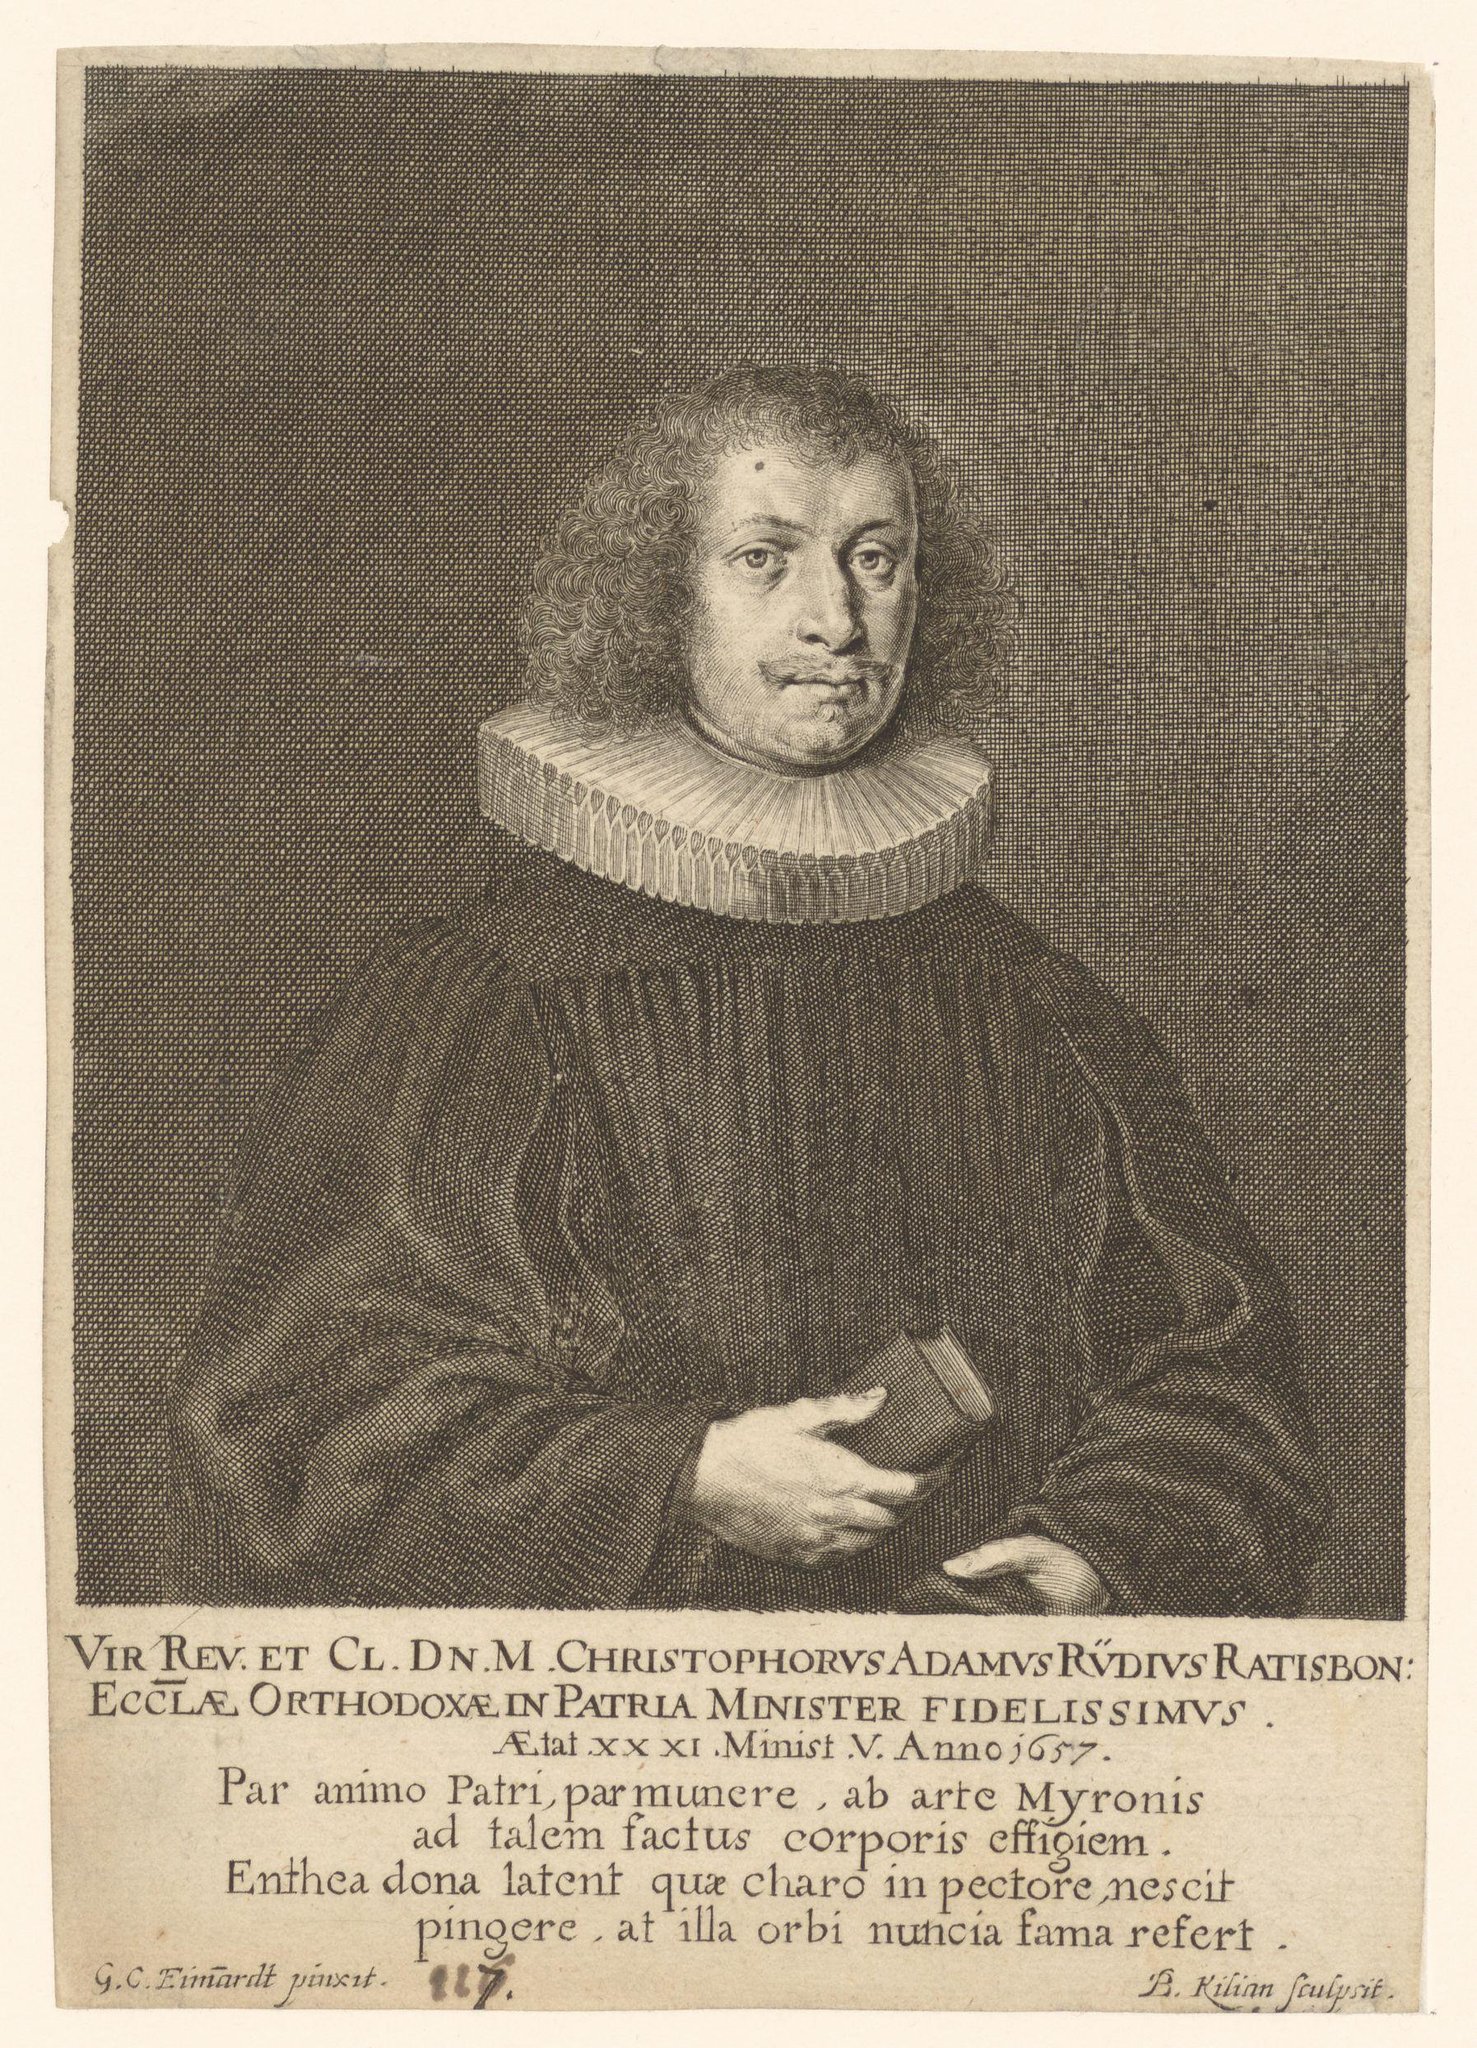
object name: print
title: Portret van Christoph Adam Rüd op 31-jarige leeftijd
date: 1657-1696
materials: paper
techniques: engraving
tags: theologian, historical persons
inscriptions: collector's mark: Lugt 2228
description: Tekst in het Latijn in de omlijsting en in de ondermarge.